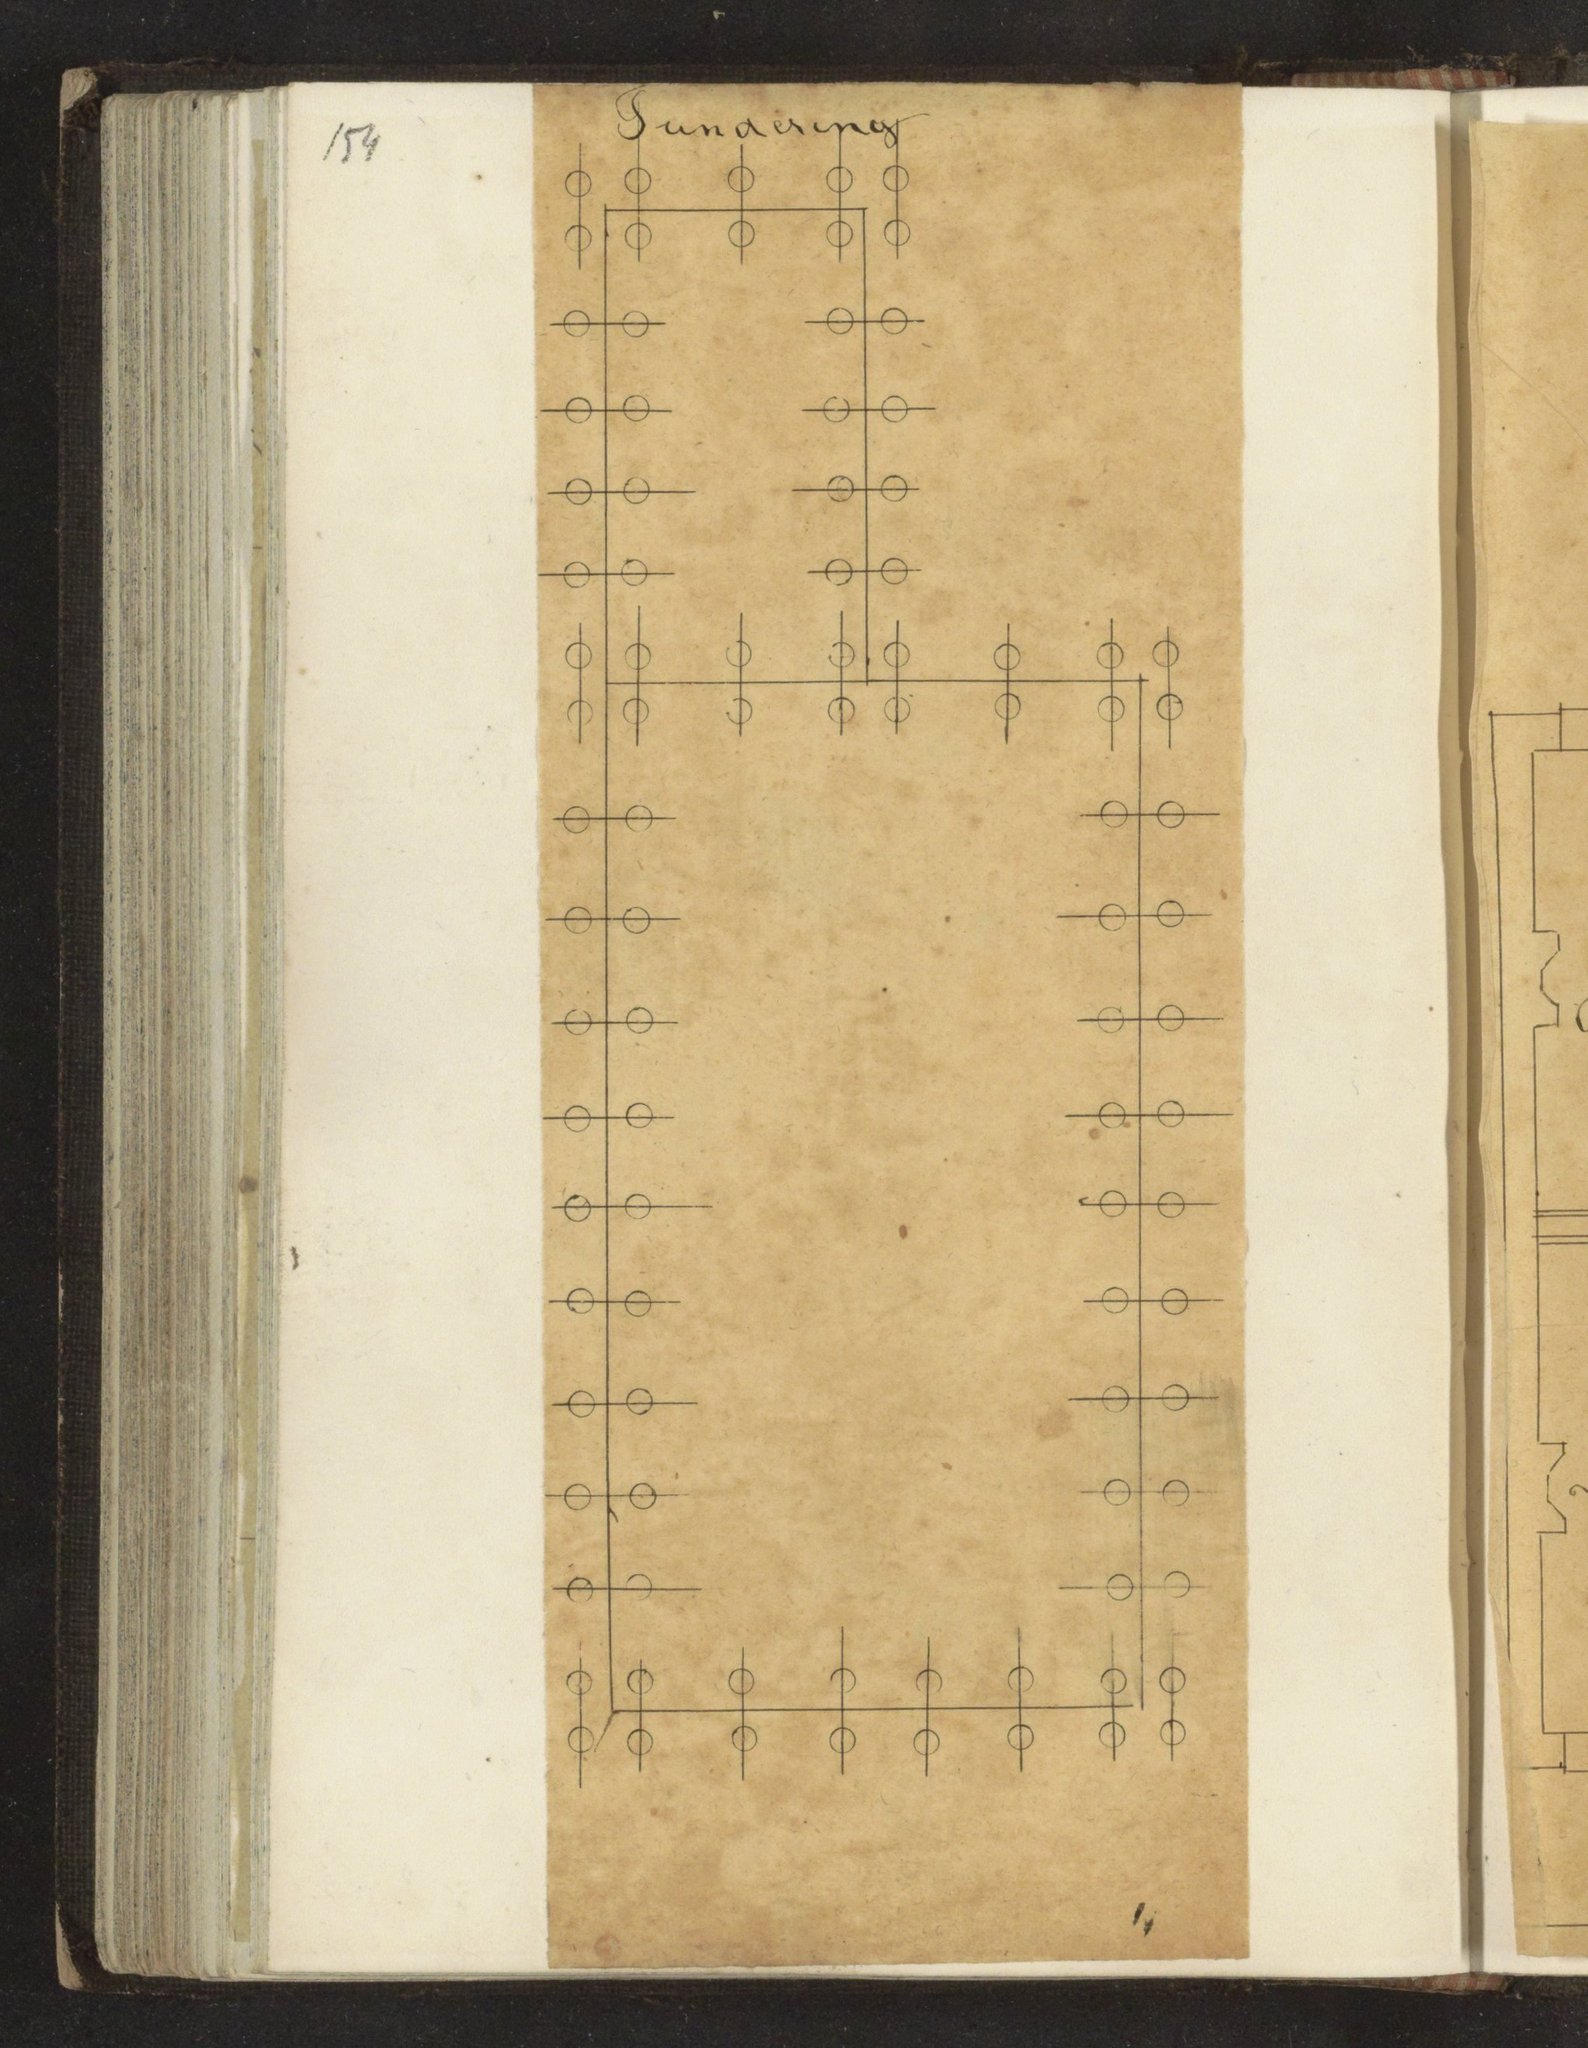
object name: sketchbook leaf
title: Fundering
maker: willem springer jr.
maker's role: draughtsman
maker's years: 1815-1907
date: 1864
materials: ink, paper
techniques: pen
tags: plan ~ architecture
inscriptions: annotation: ‘Fundering’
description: Pagina 154 uit een schetsboek met 164 pagina's.